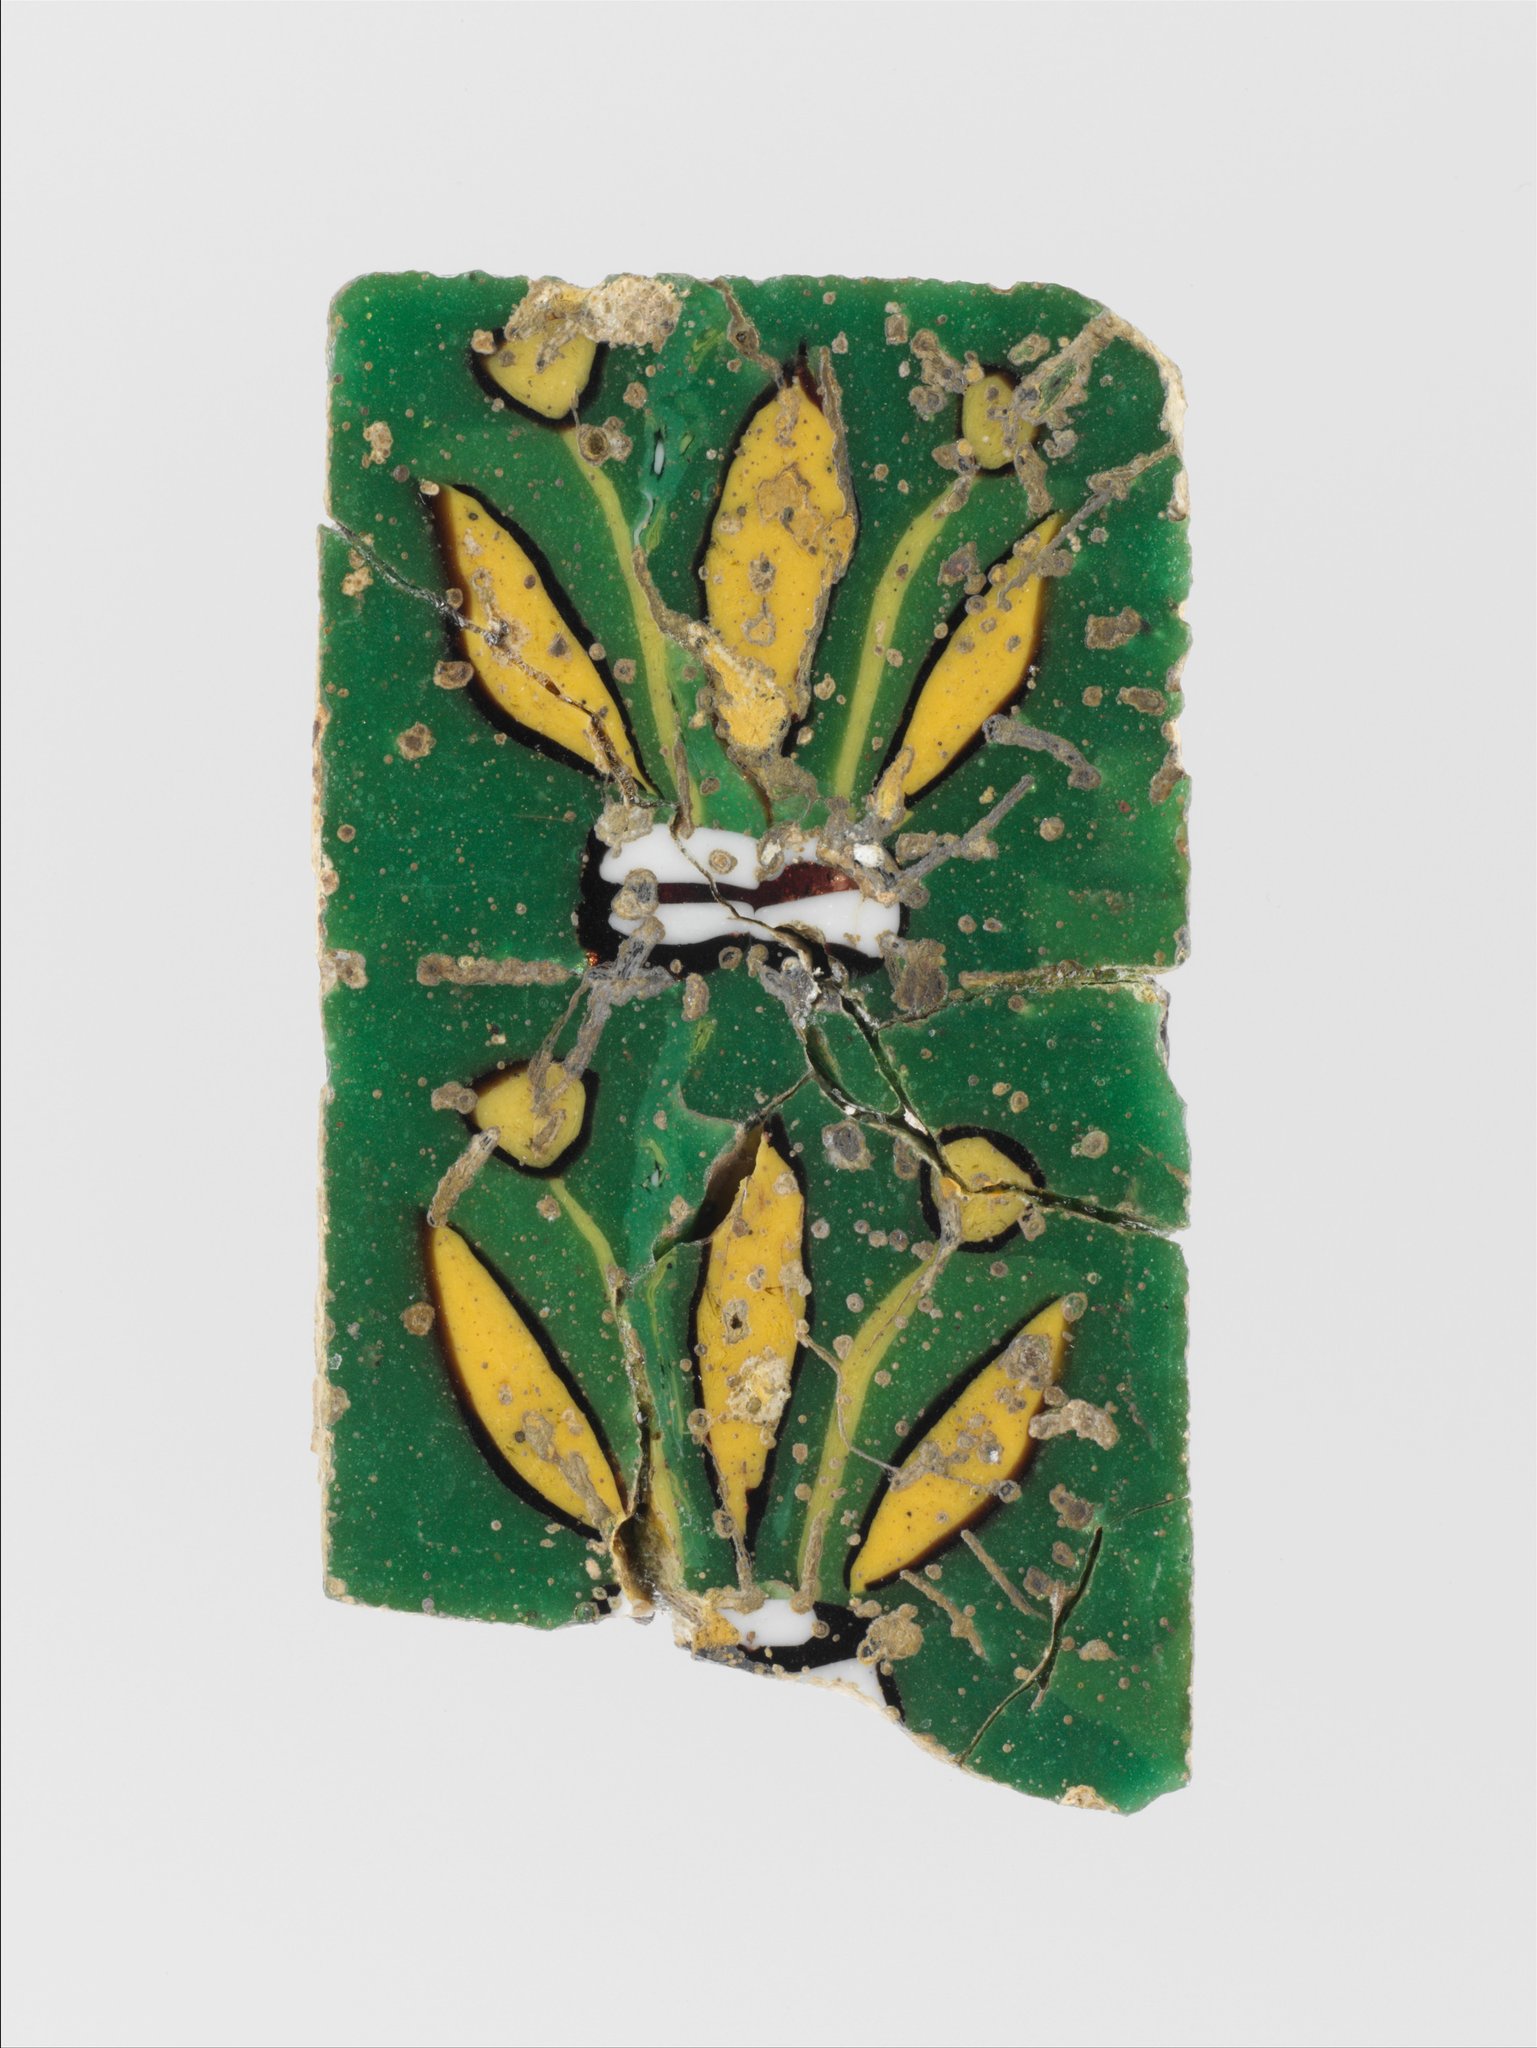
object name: mosaic block inlay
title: Glass mosaic inlay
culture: egyptian or ptolemaic or roman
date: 100 BCE-100 CE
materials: glass